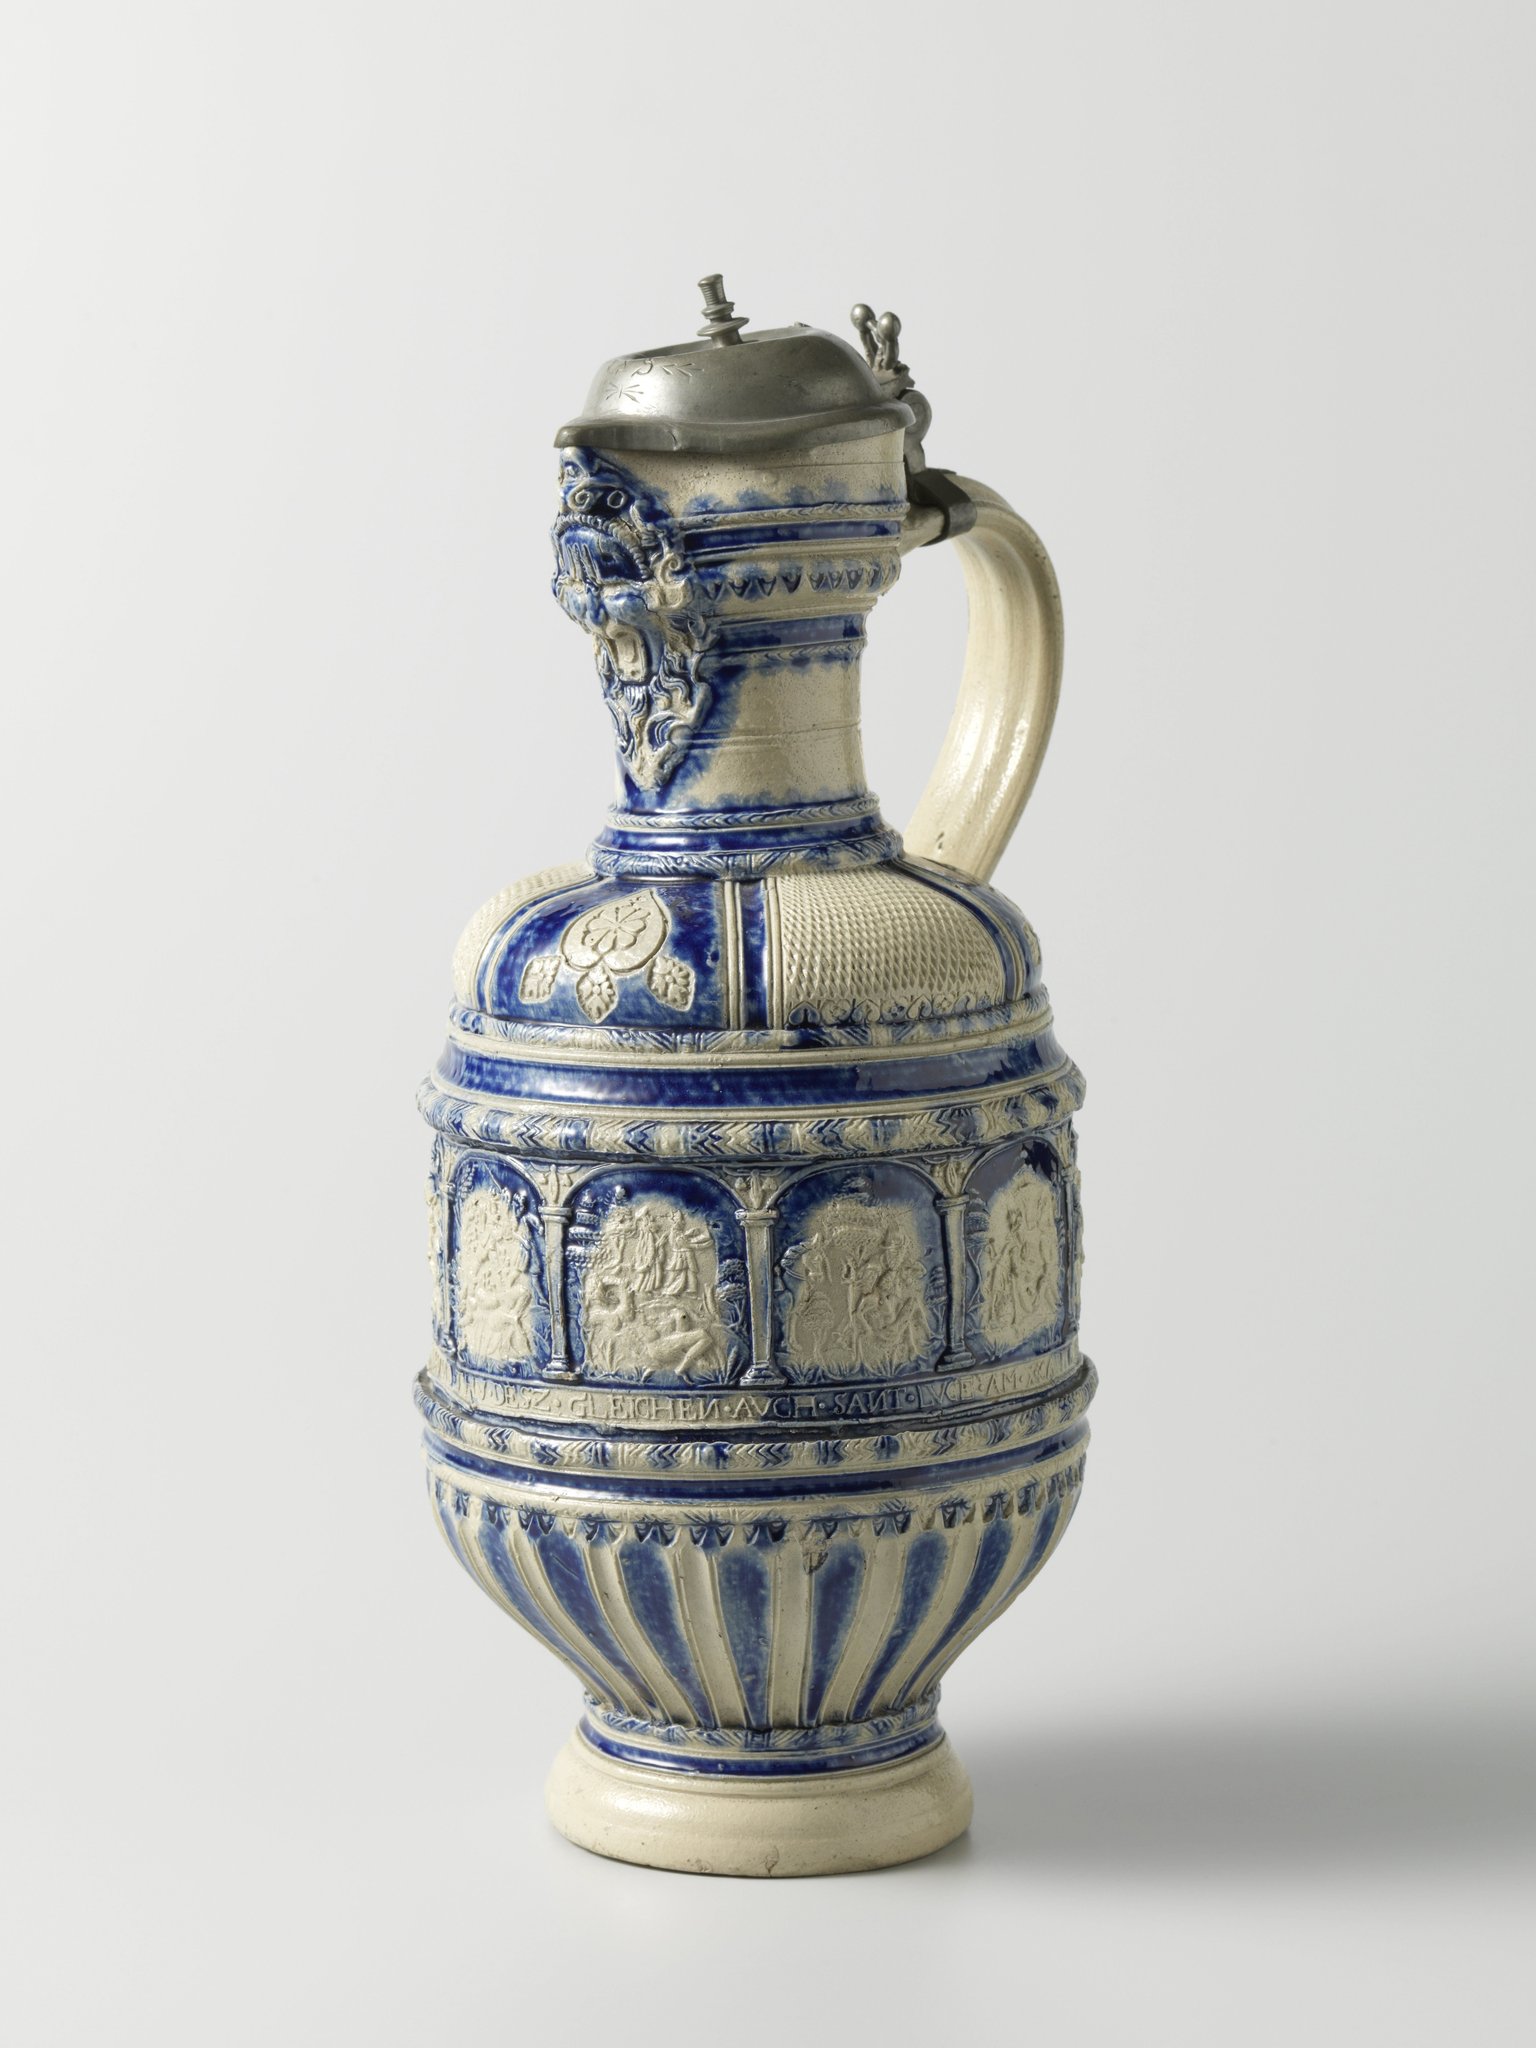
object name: jug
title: Jug with the Good Samaritan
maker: Anonymous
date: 1619-1630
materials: cobalt, glaze, stoneware, tin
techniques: printing, firing, forming, relief, turning, vitrification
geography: westerwald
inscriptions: inscription: ‘DA SPRACH IHSVS ZU IHM SO GEHE DU HIN UND THV DESZ GLEICHEN AUCH SANT LVCE AM X CAPITEL’, mark: ‘I.C.’, date: ‘1619’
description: Fragment van een kruik van steengoed op hoge voet met een cilindrisch lichaam met ronde schouder en smalle nek met geknepen tuit. Het oor is bevestigd aan de nek en de schouder. Profielen op de nek, buik en voet. Op het cilindrische deel van de buik in reliëf een gedrukte en opgelegde band met de geschiedenis van de Barmhartige Samaritaan. Daaronder het opschrift 'DA SPRACH IHSVS ZU IHM SO GEHE DU HIN UND THV DESZ GLEICHEN AUCH SANT LVCE AM X CAPITEL 1619' en het merk 'I.C.'. Het onderste deel van de buik loopt in canelures schuin af naar de voet. De schouder is verdeeld in vakken met afwisselend gestempelde rozetten of kerfsnede. Op de nek een leeuwenkop in reliëf. Bevestigd aan het oor een tinnen montuur met deksel en dekselknop. Op de deksel het merk 'C.S.'. Westerwald.